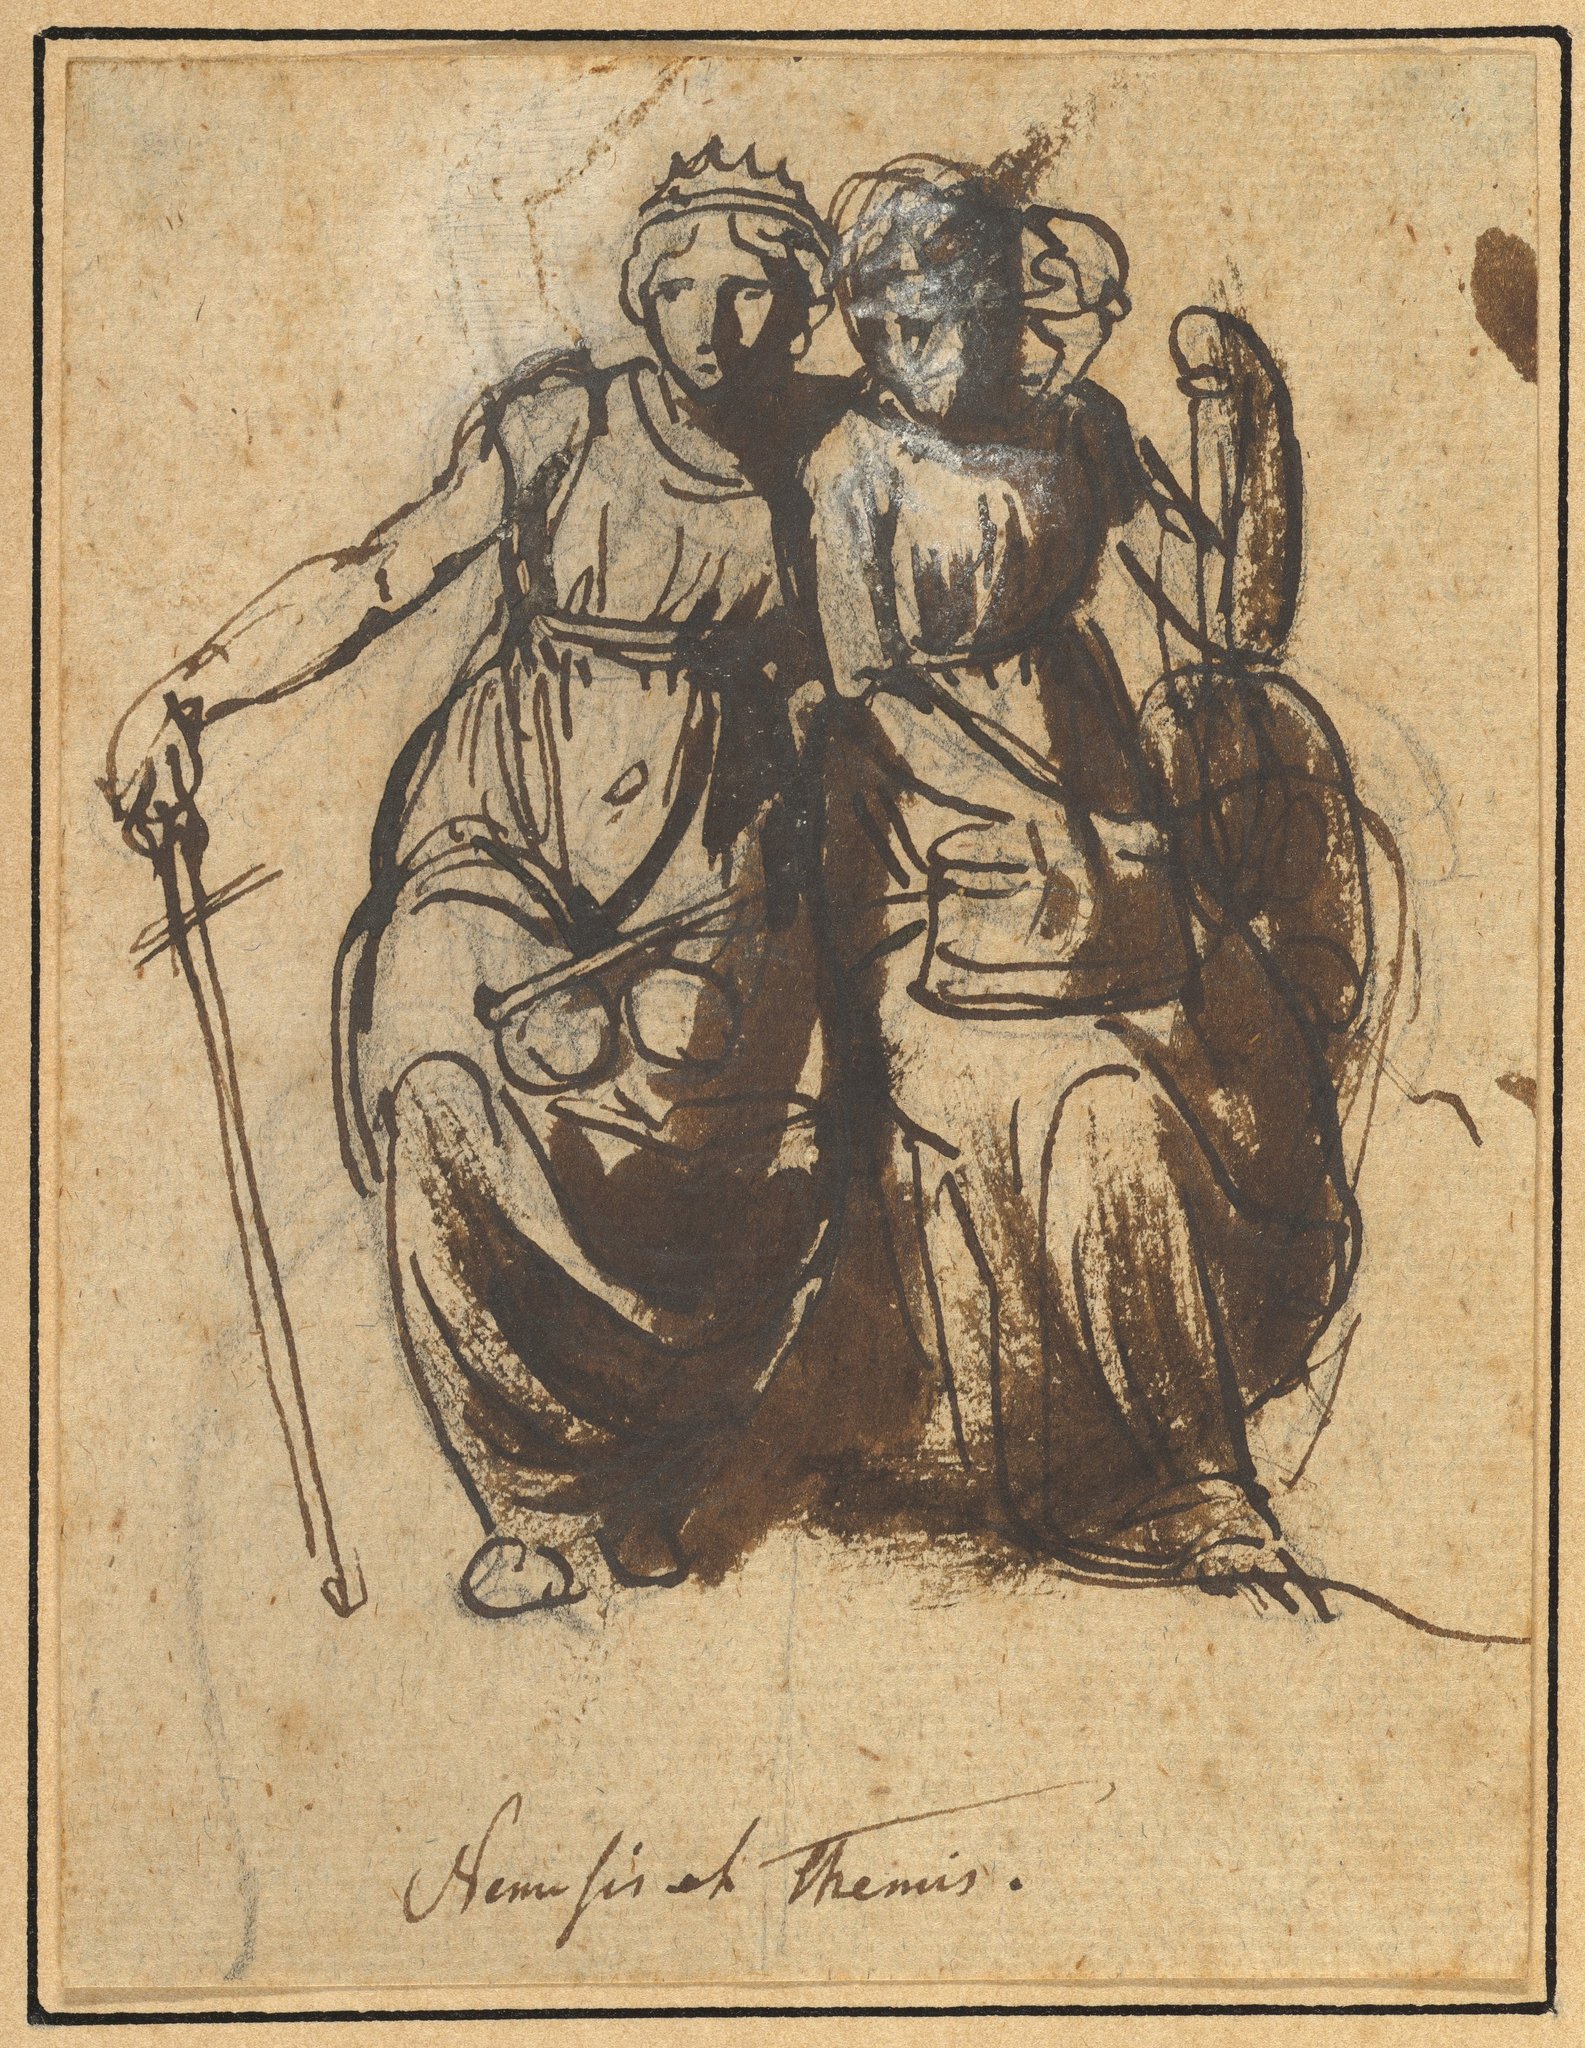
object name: drawing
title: Nemesis and Themis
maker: nicolai abraham abildgaard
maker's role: artist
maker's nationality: danish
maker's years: 1743-1809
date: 1734-1833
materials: chalk, gouache, ink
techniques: heightening, pen, wash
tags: women